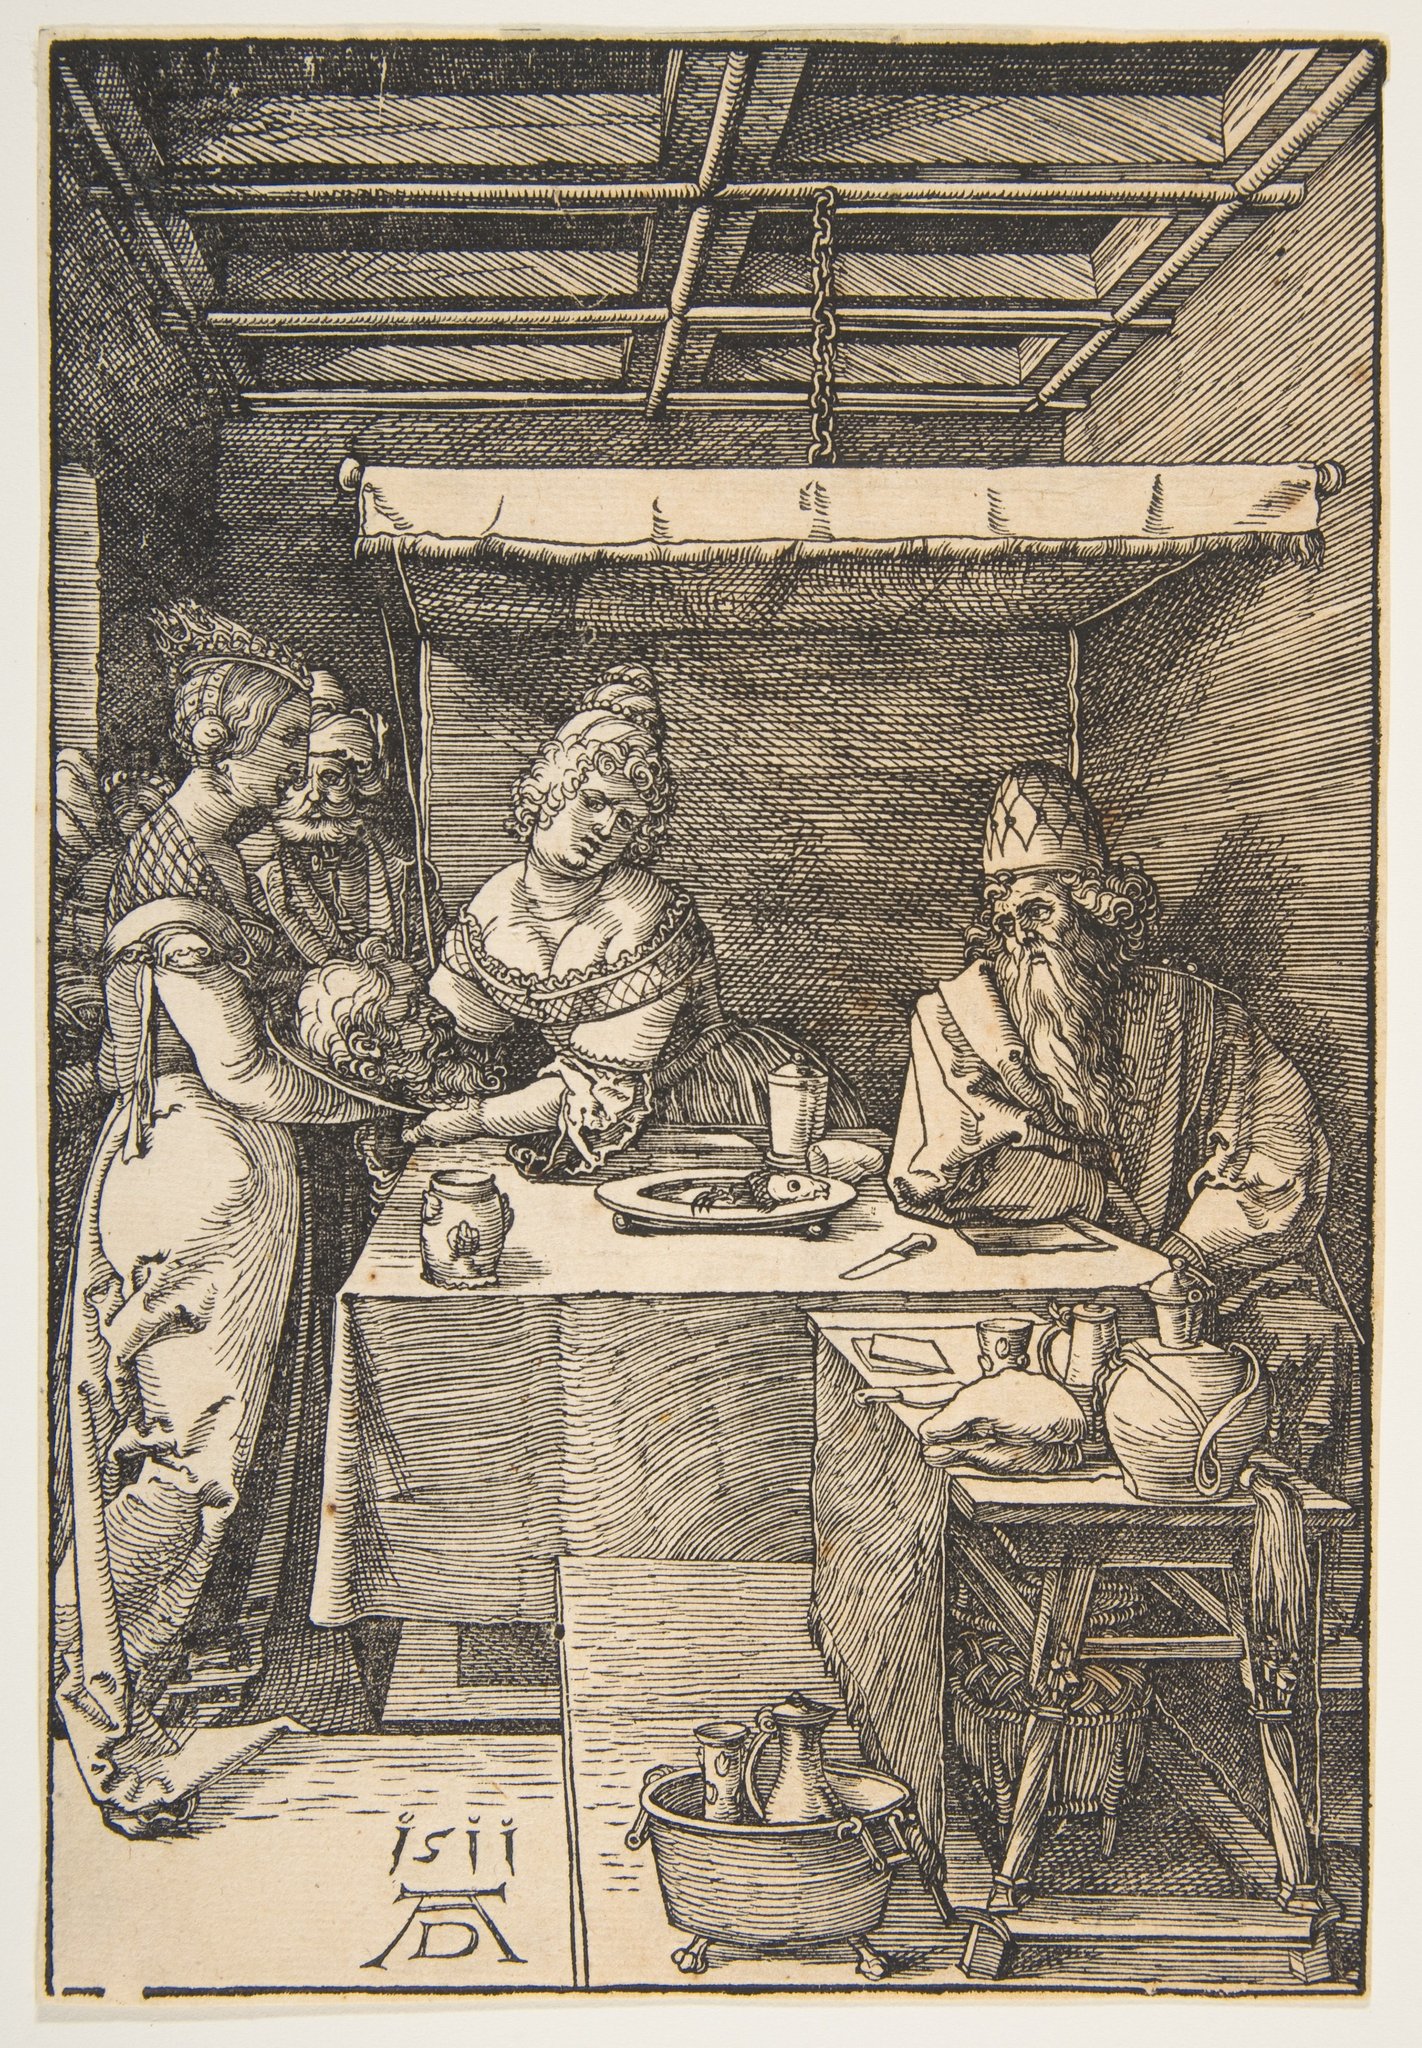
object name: print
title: Salome Receiving the Head of Saint John the Baptist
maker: albrecht dürer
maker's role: artist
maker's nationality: german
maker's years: 1471-1528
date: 1511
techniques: woodcut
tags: men,women,saint john the baptist